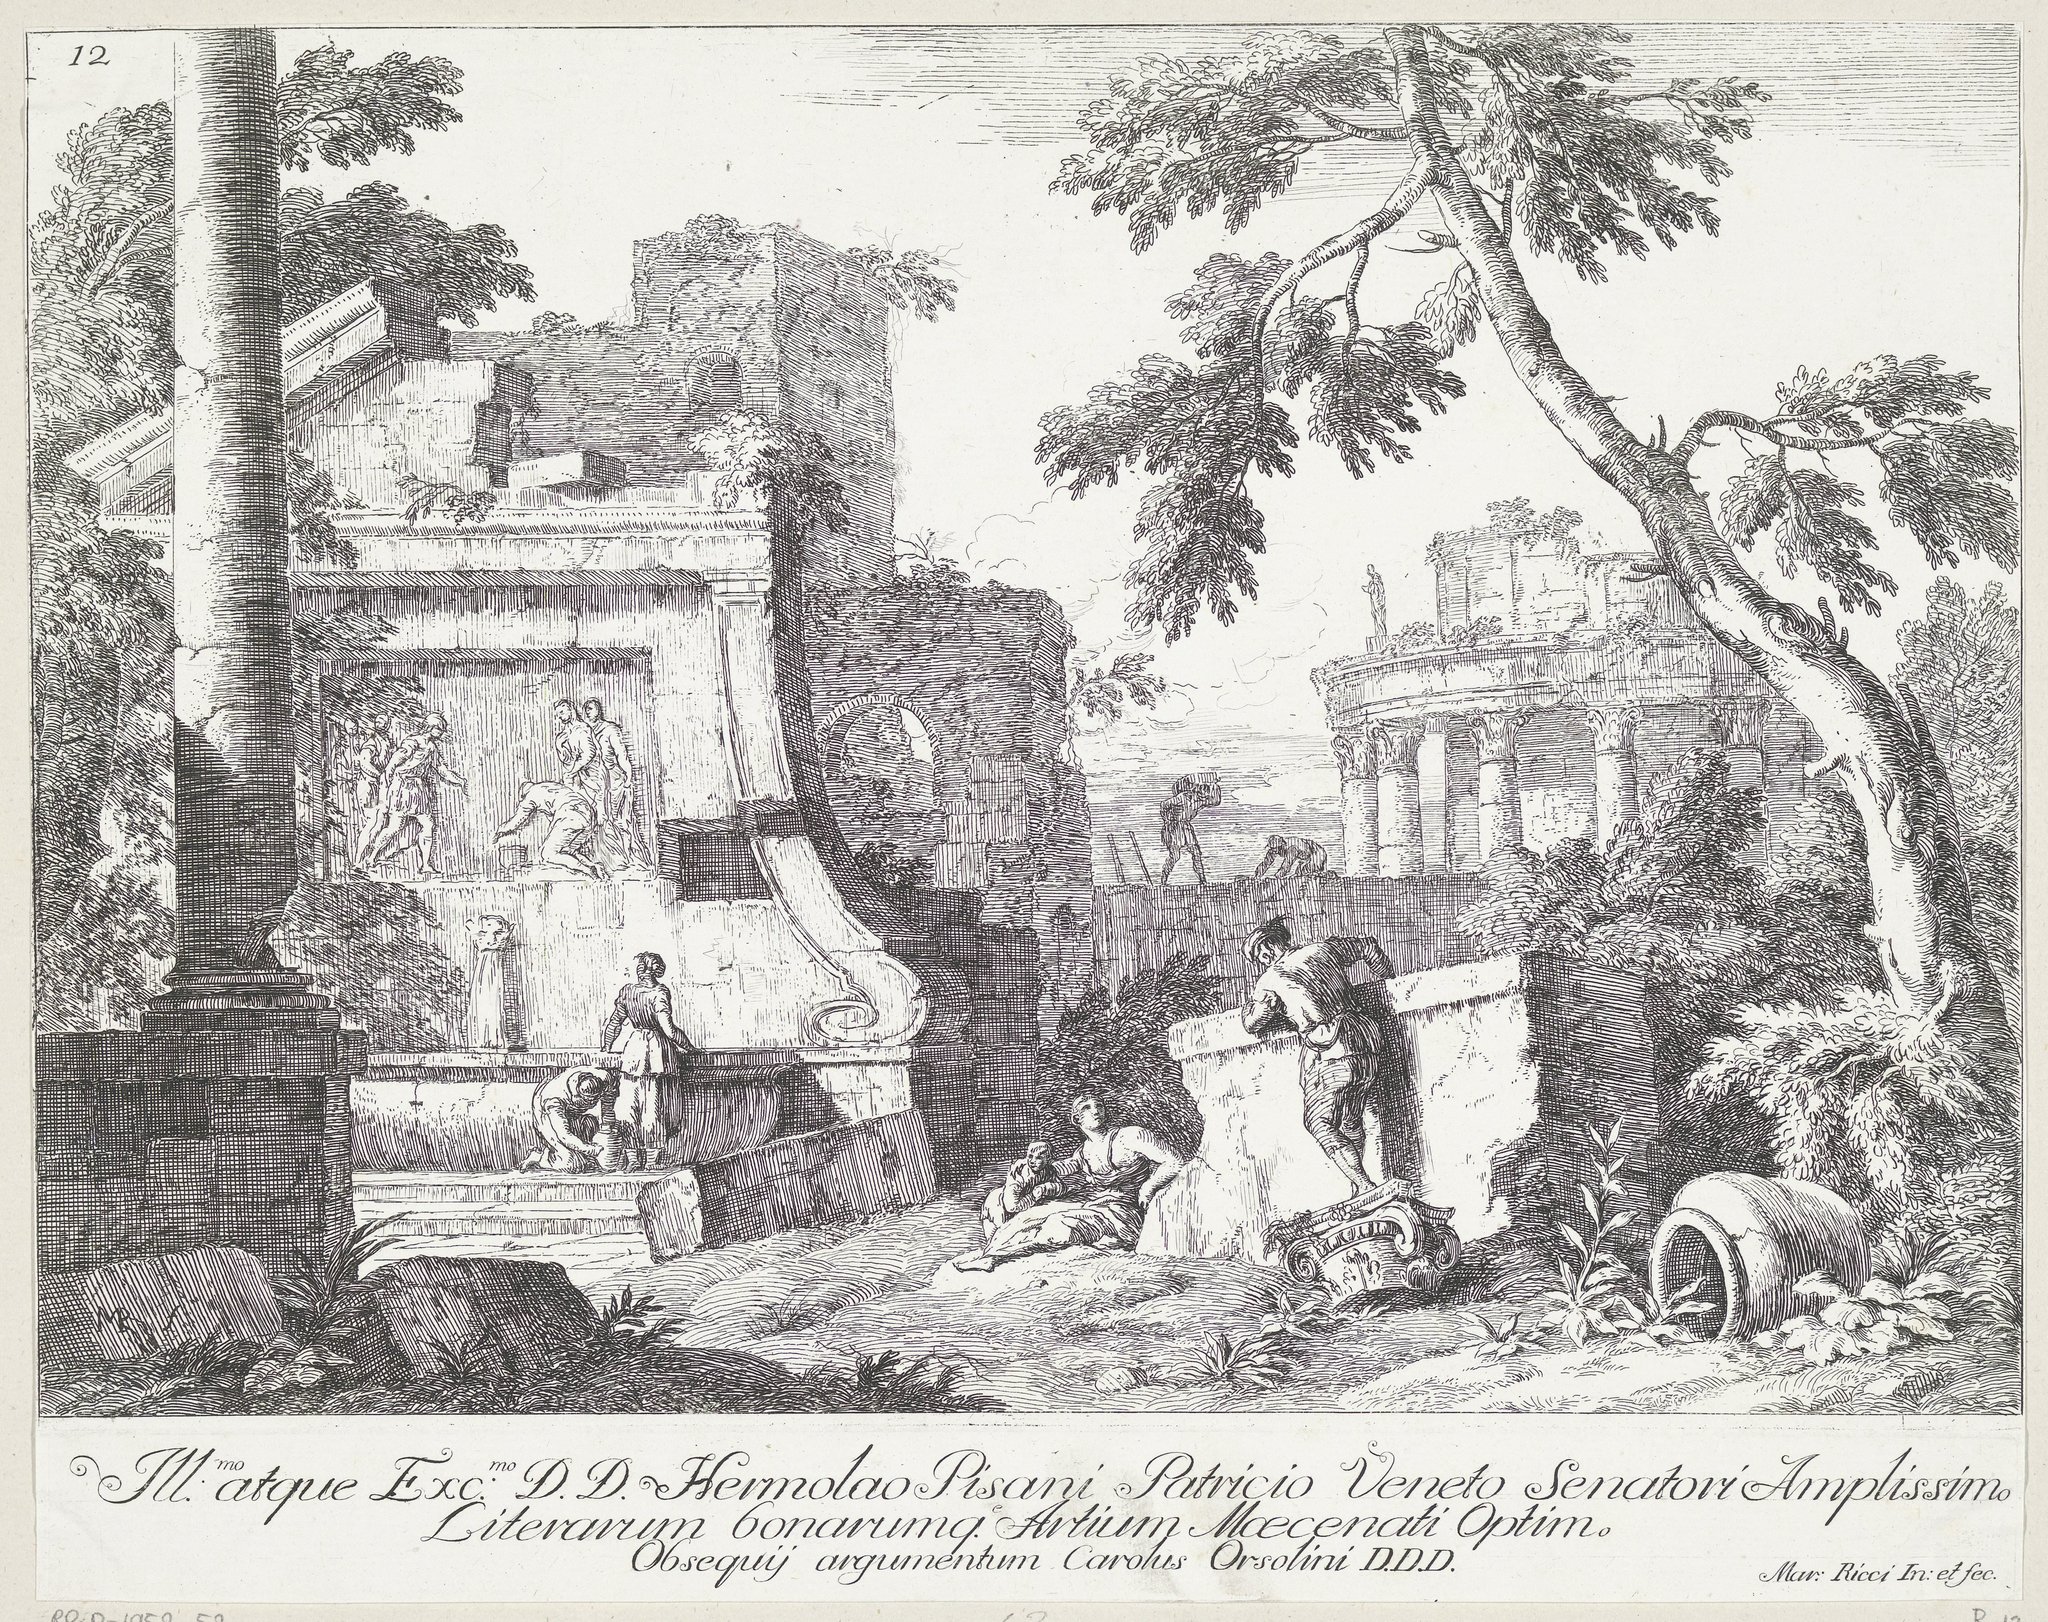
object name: print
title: Landschap met ruïnes en waterbassin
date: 1730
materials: paper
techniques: etching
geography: italy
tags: landscapes, ruin of a building ~ architecture, ornamental fountain, landscape with ruins - ii - ideal landscapes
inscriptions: collector's mark: Lugt 2228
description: Deze prent maakt deel uit van een reeks van twintig prenten door Marco Ricci. De prenten zijn na de dood van Ricci in 1730 gebundeld door Carlo Orsolini en voorzien van een titelprent.